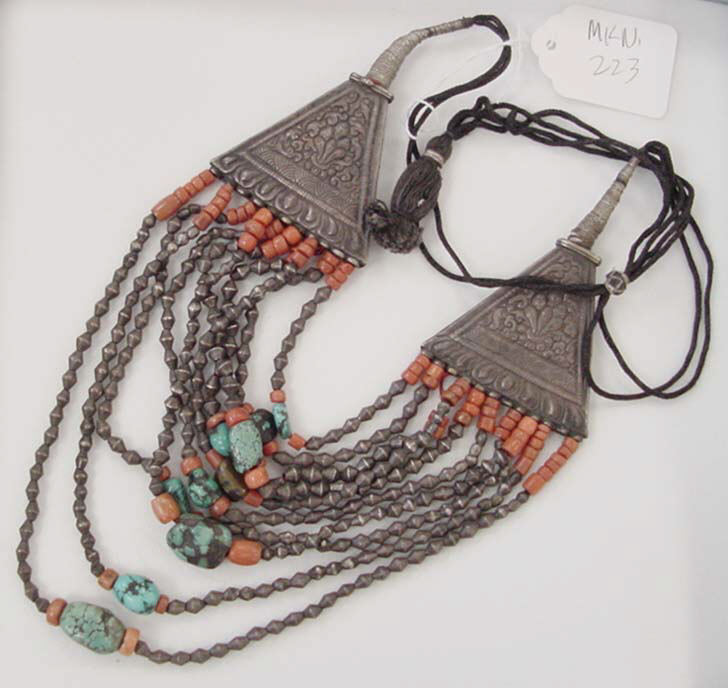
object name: necklace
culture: tibetan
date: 1801-1900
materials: coral, metal, silk